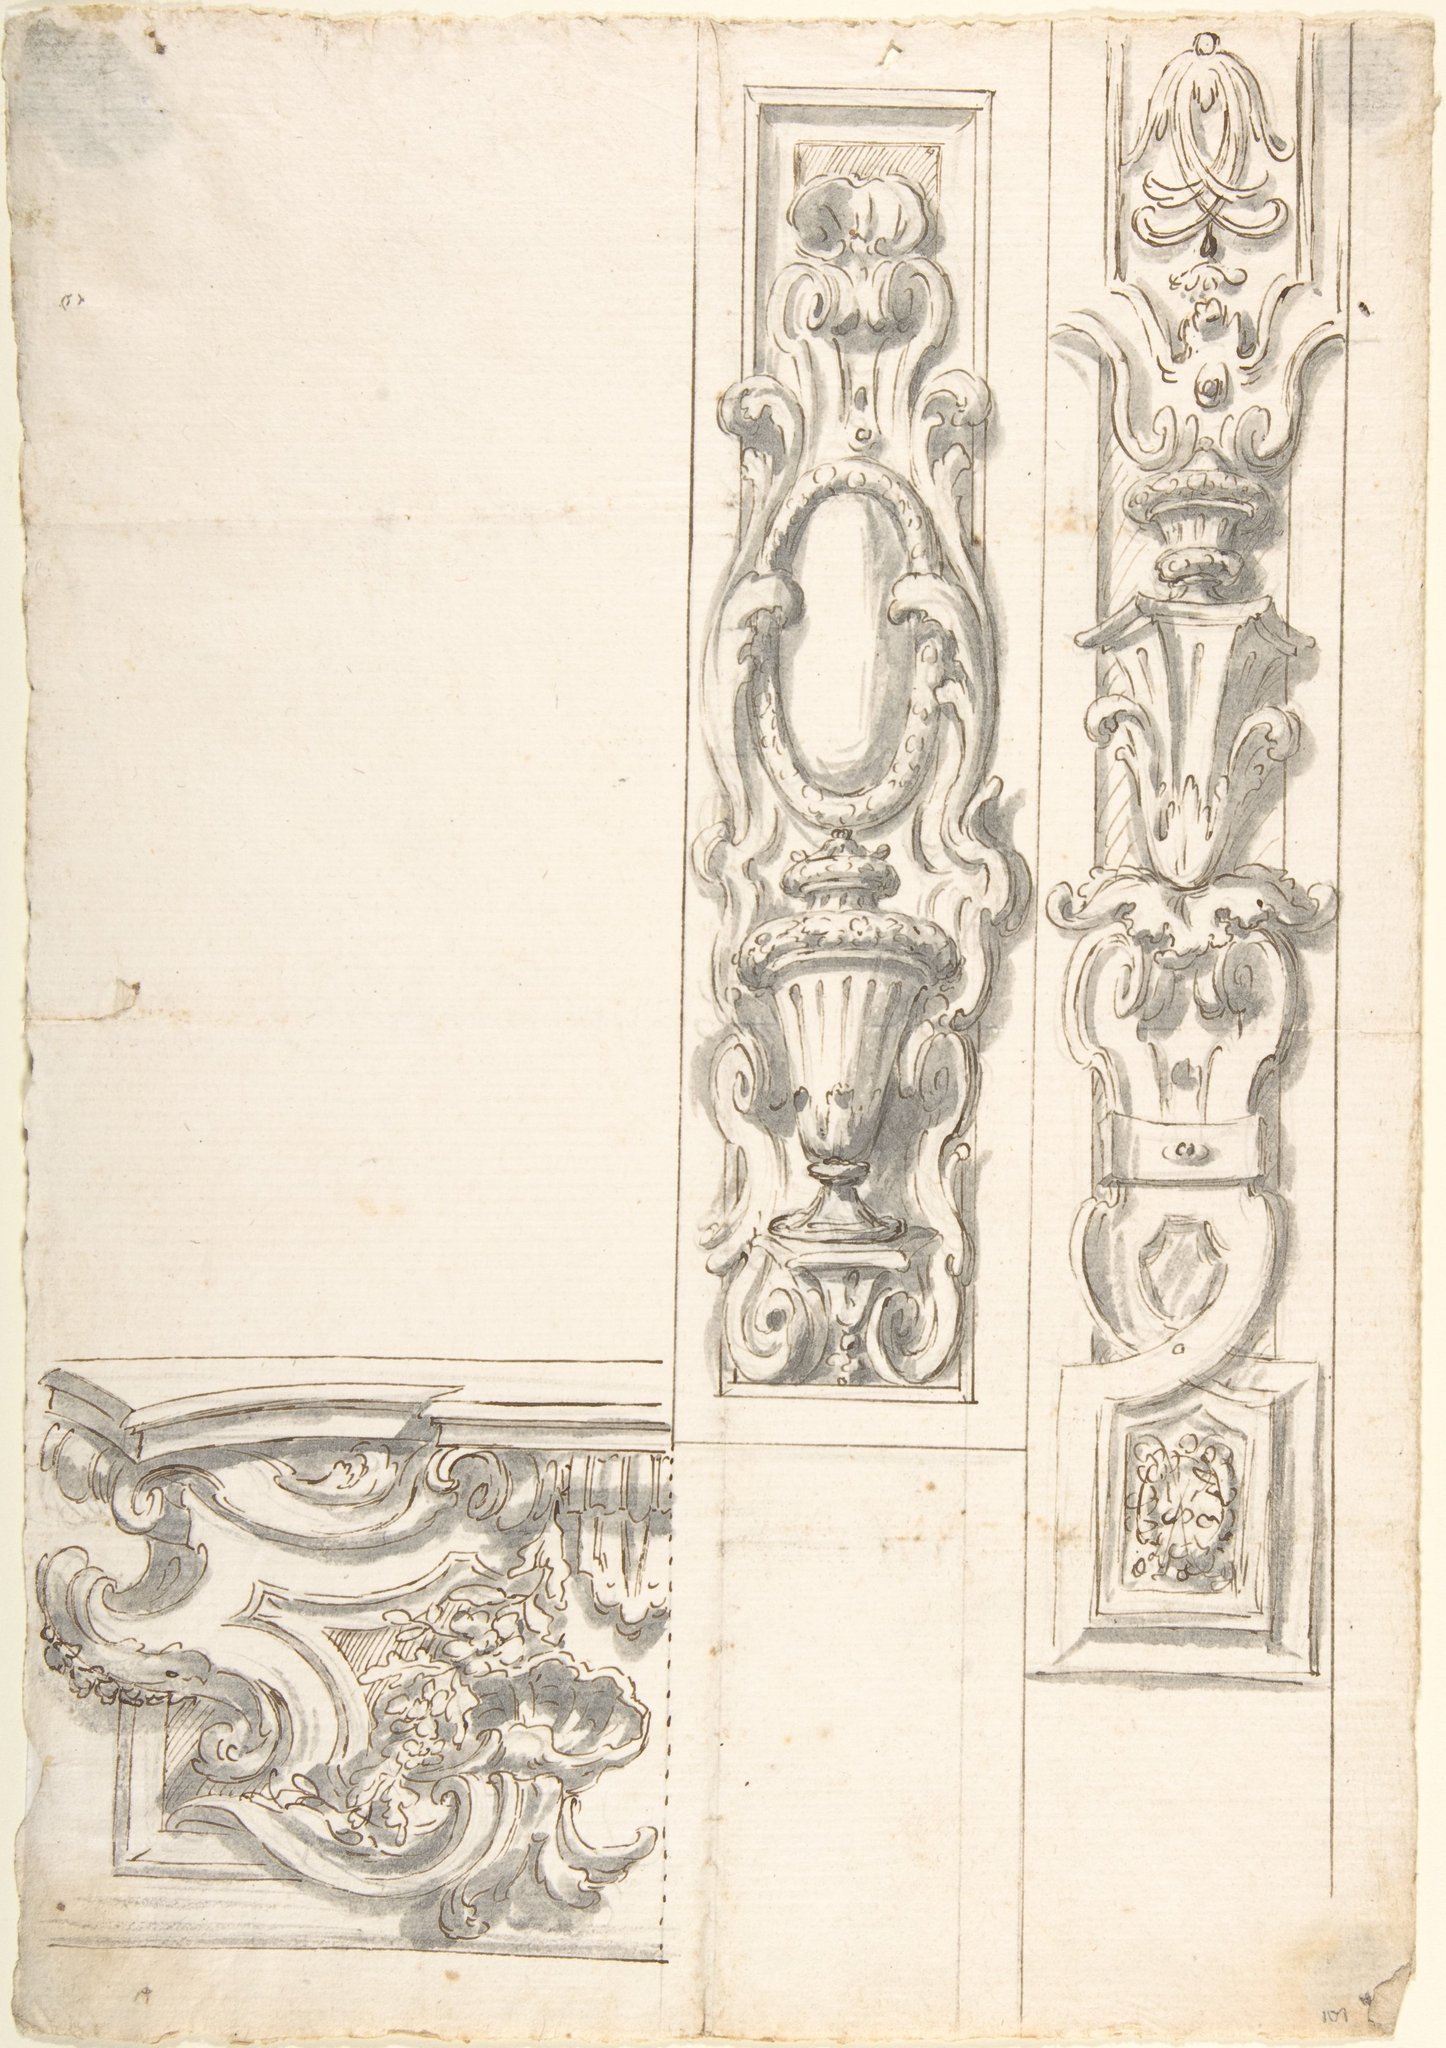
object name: drawing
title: Design for Two Ornamental Upright Panels, and one Ornamental Basamento (?)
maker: anonymous, italian, piedmontese, 18th century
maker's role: artist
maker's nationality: italian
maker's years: 1700-1800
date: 1700-1780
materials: graphite, ink, drawing material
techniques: brush, pen, wash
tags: ornament